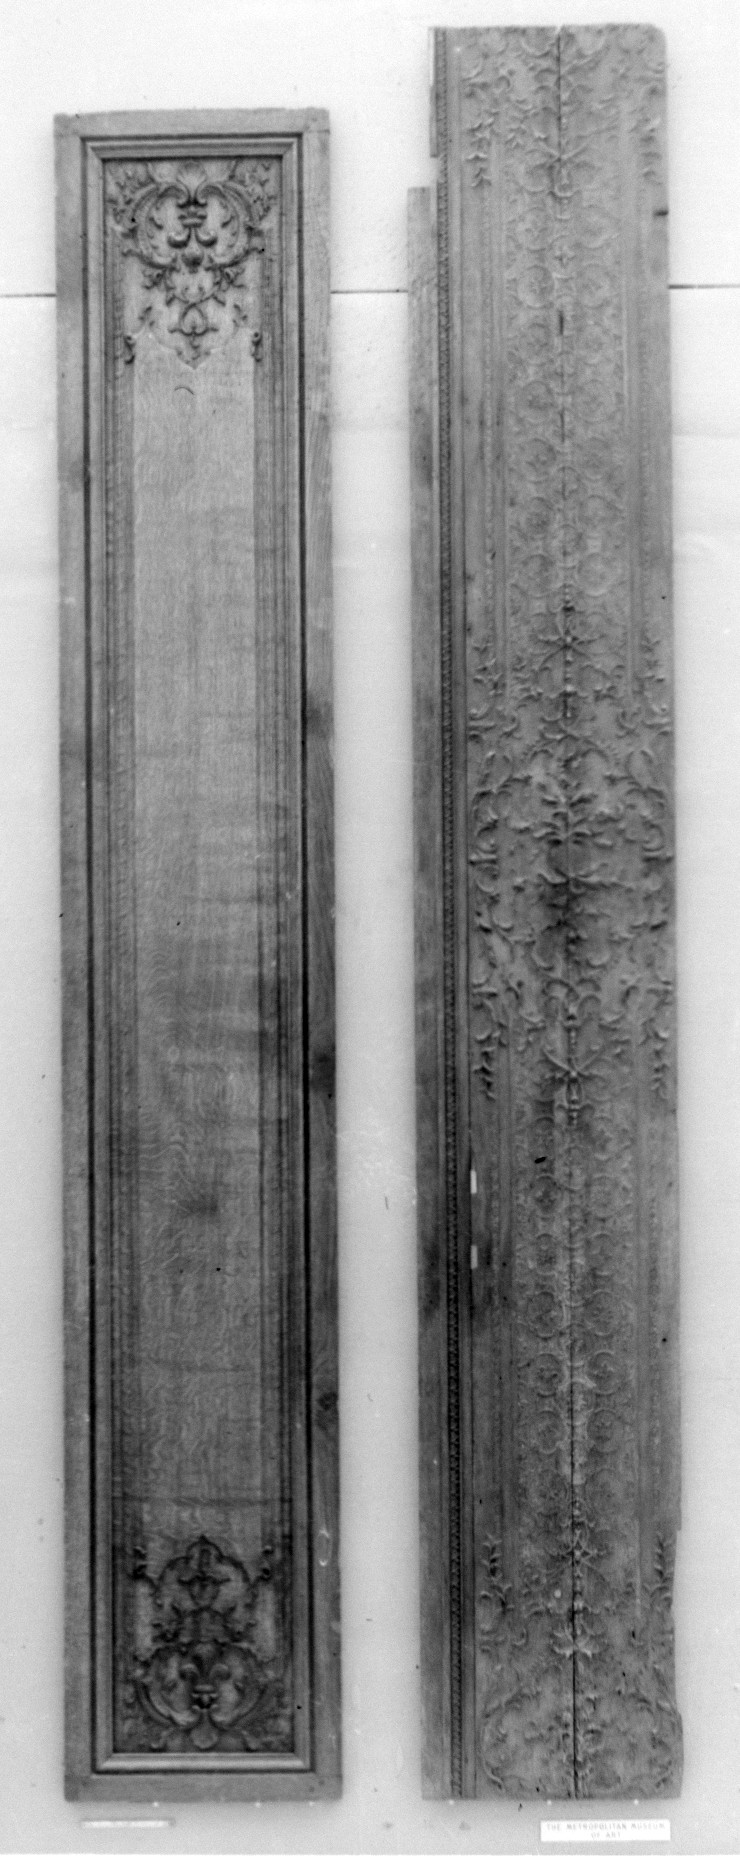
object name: panel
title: Panel (parclose)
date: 1701-1733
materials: wood